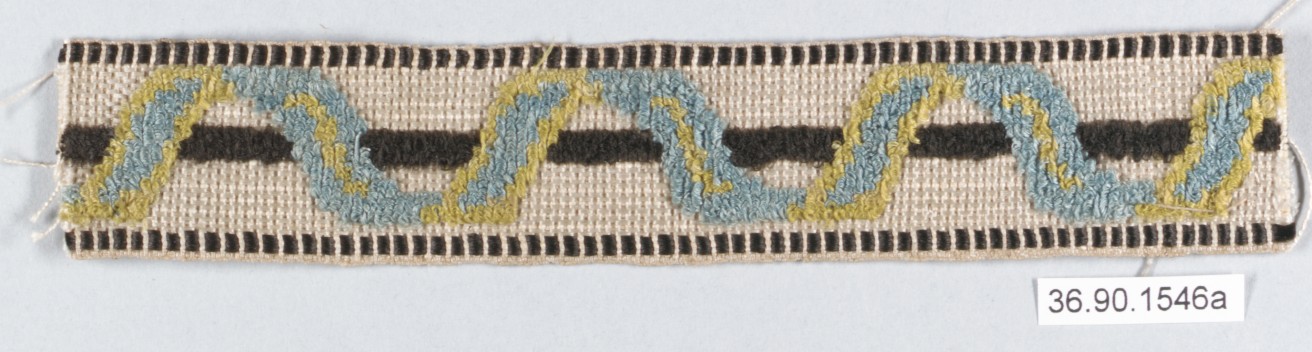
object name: galloon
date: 1701-1900